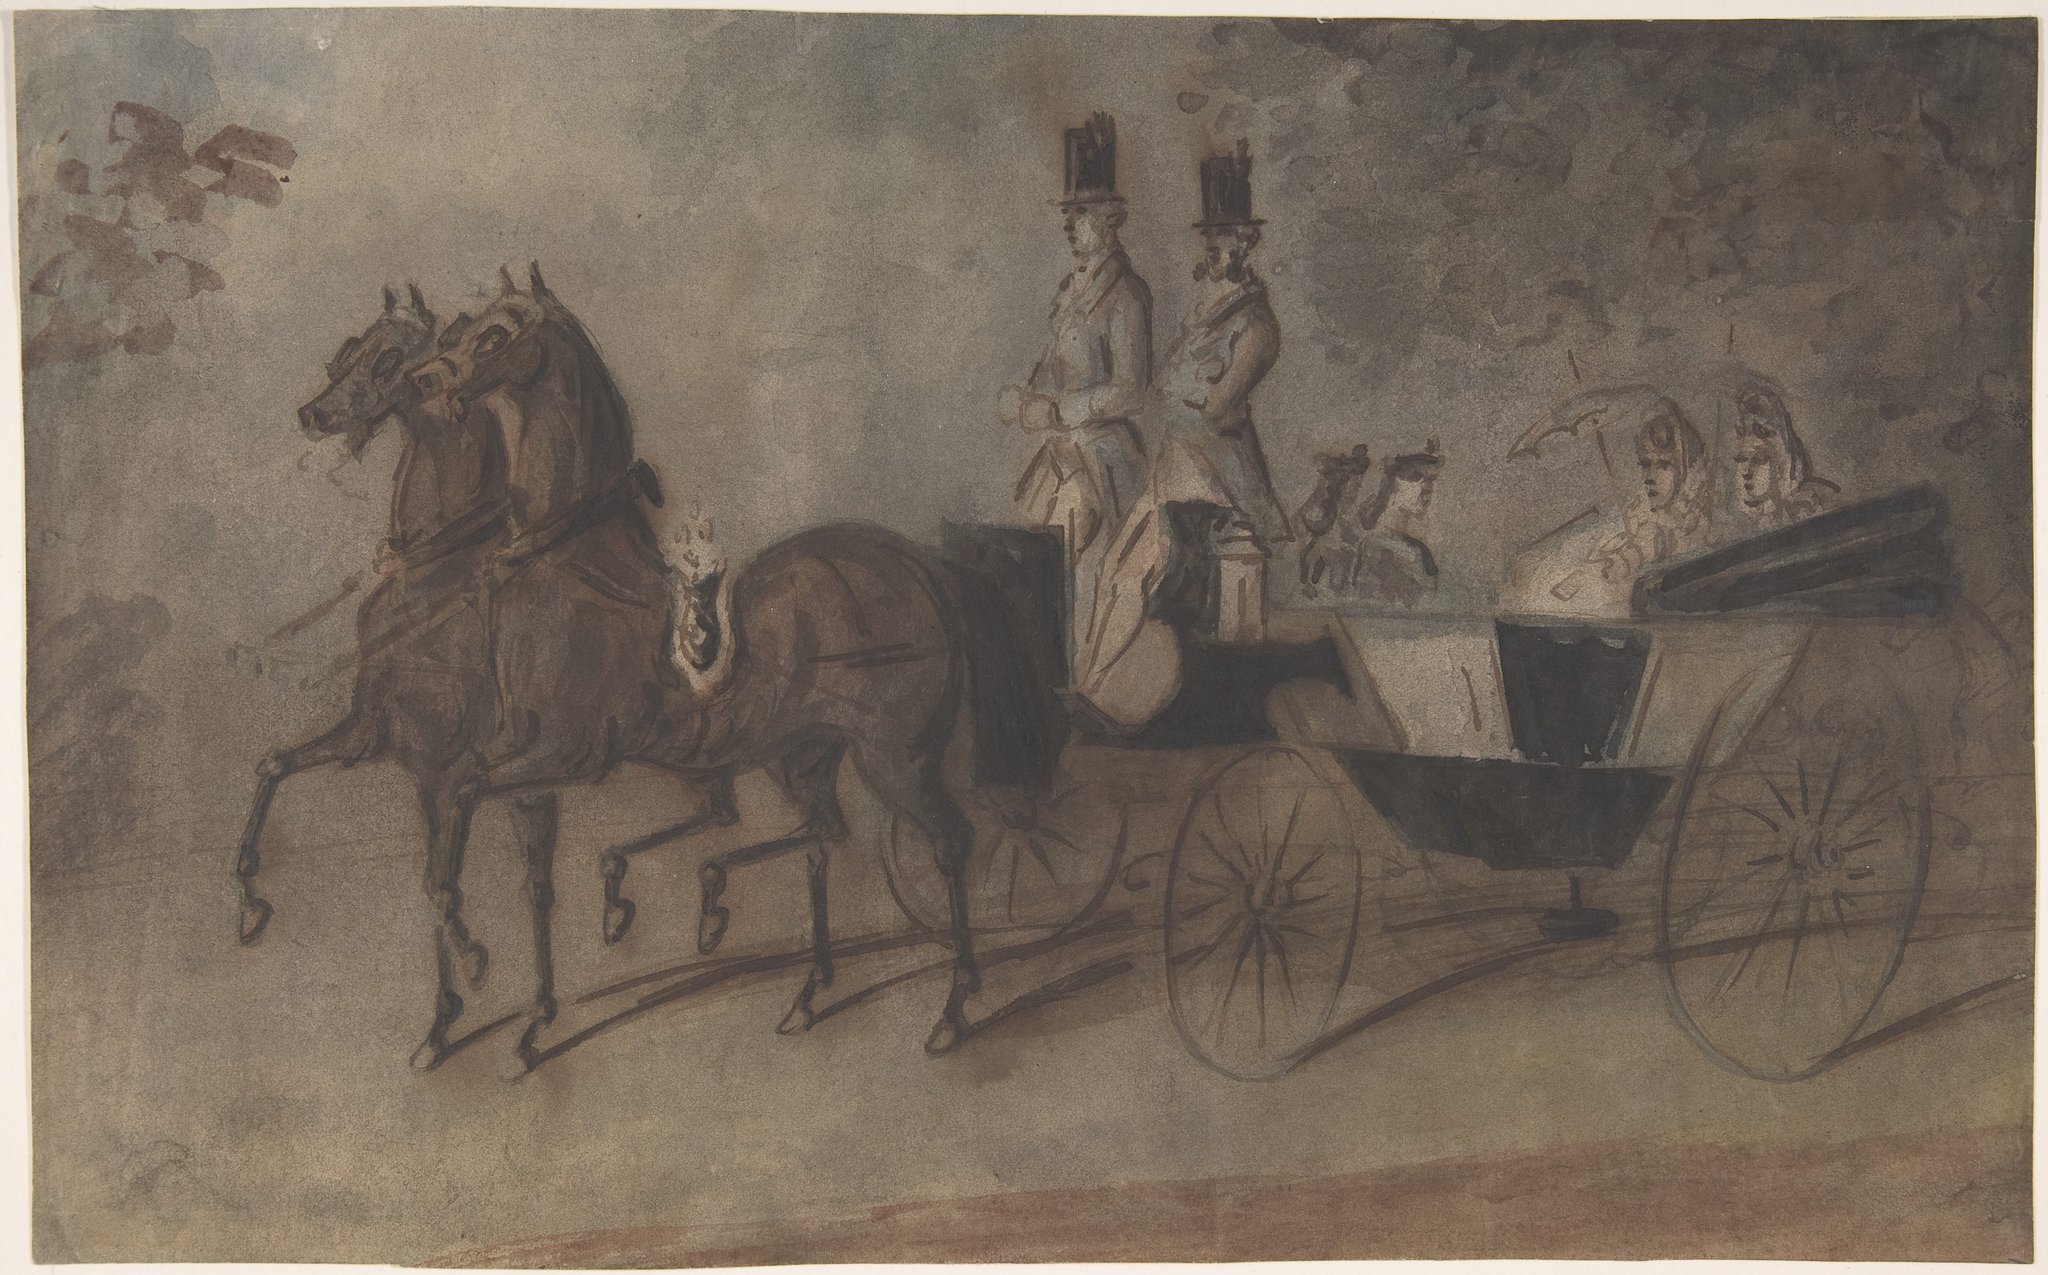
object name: drawing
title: Women in a Carriage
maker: constantin guys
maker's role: artist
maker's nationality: french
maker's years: 1802-1892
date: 1801-1900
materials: ink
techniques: pen, wash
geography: france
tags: men,women,horses,carriages